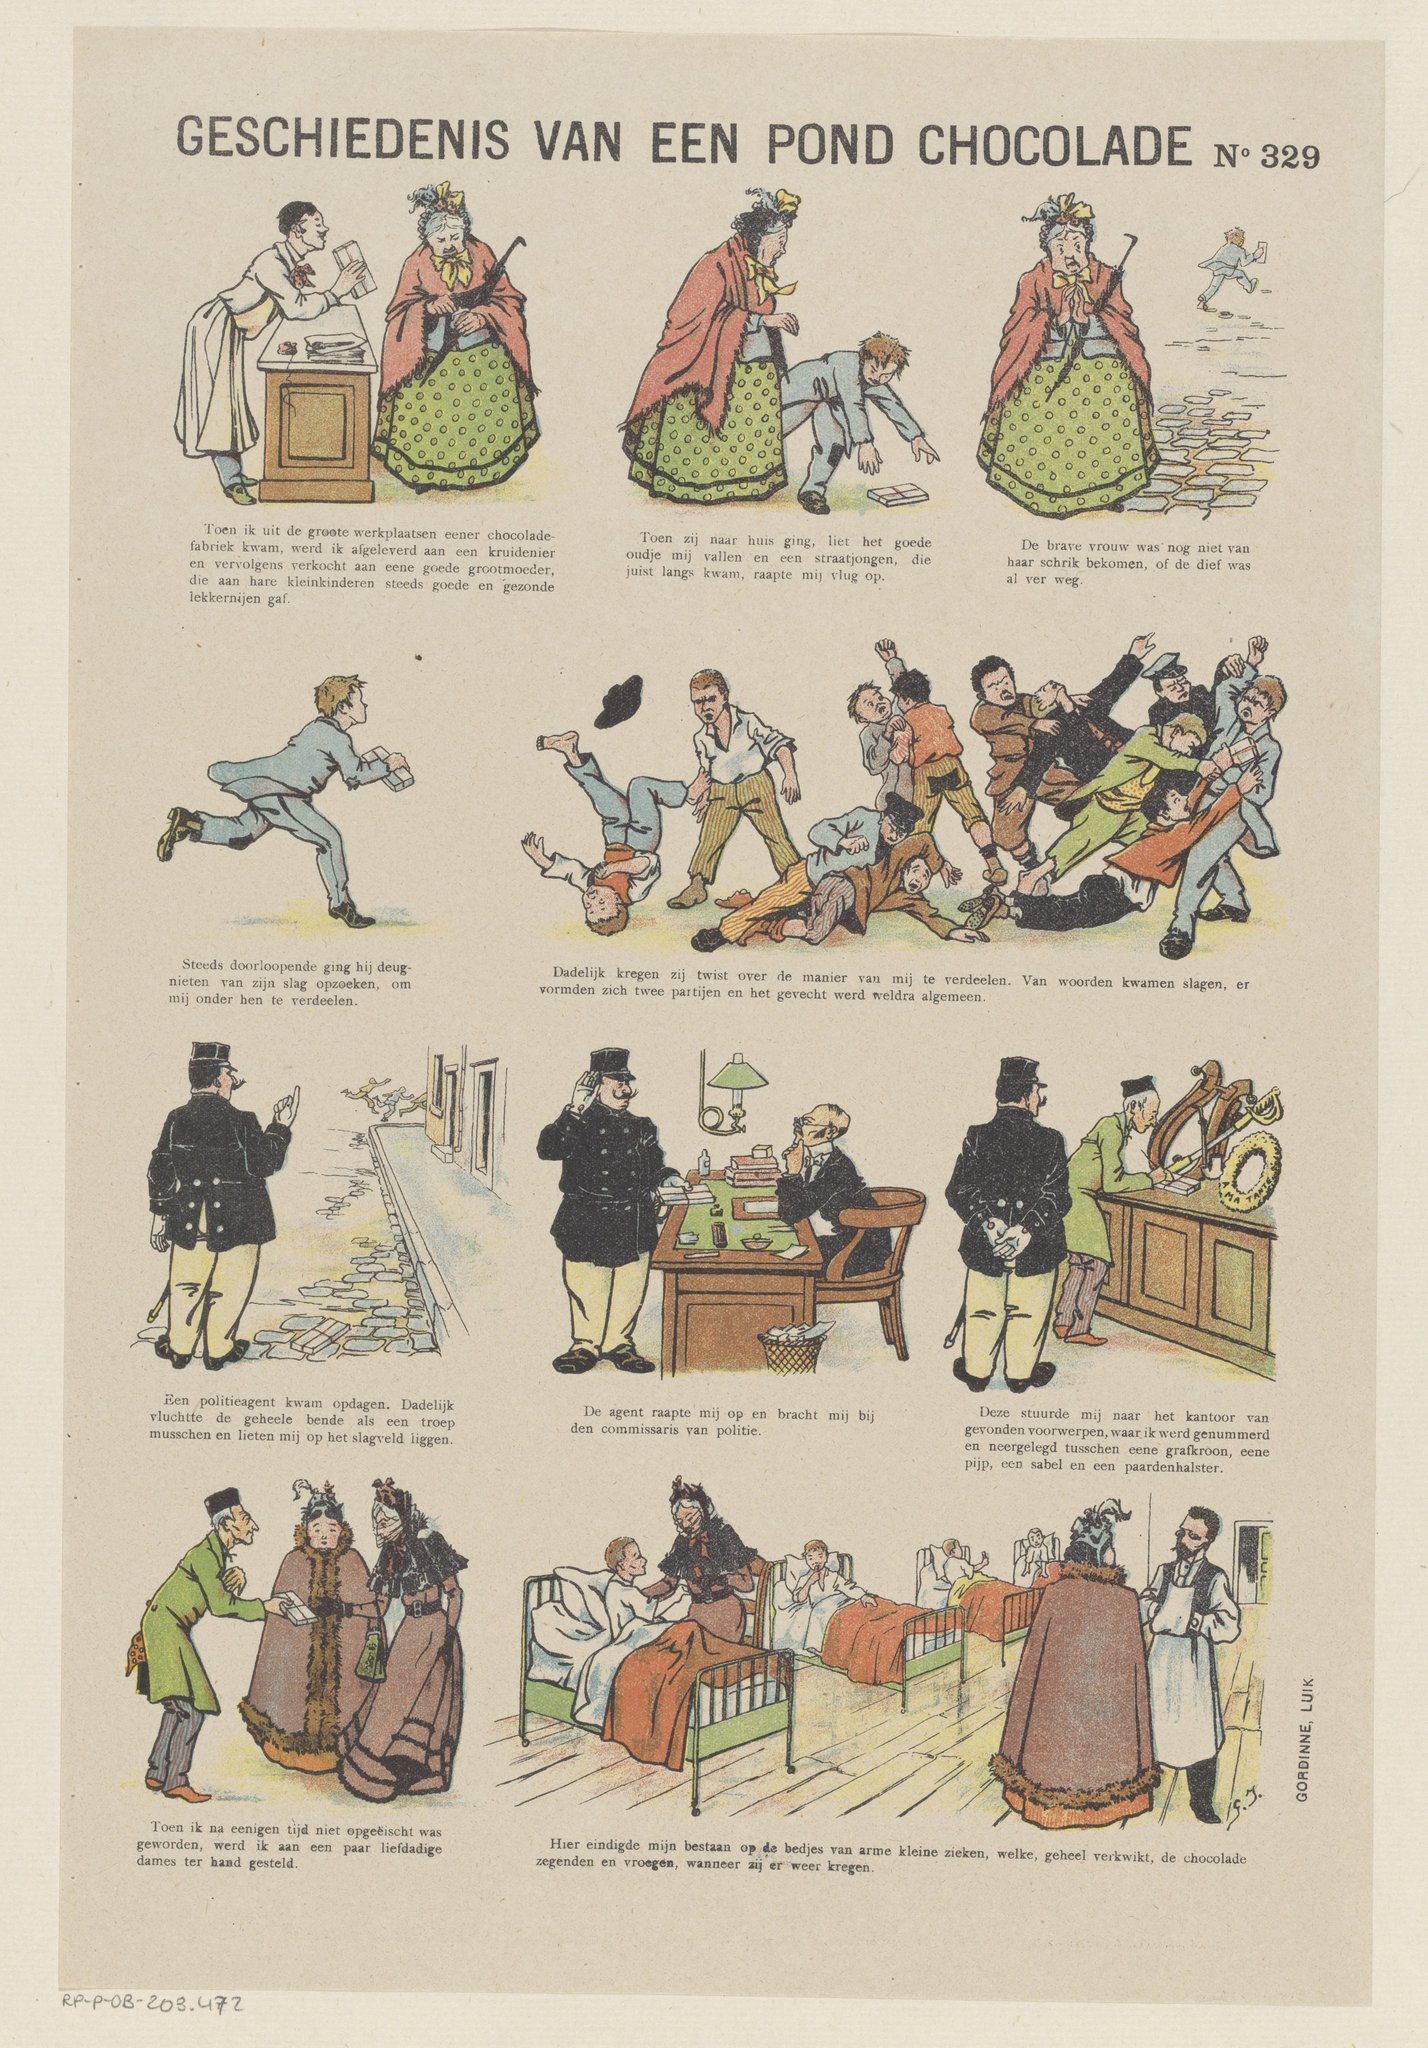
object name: print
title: Geschiedenis van een pond chocolade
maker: monogrammist g.j.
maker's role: print maker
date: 1894-1959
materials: paper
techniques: lithograph, letterpress printing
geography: liège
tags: chocolate (solid)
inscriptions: collector's mark: Lugt 2760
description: Blad met 10 voorstellingen over een pond chocolade die meerdere malen van eigenaar verwisselt. Onder elke afbeelding een onderschrift. Genummerd rechtsboven: No 329.